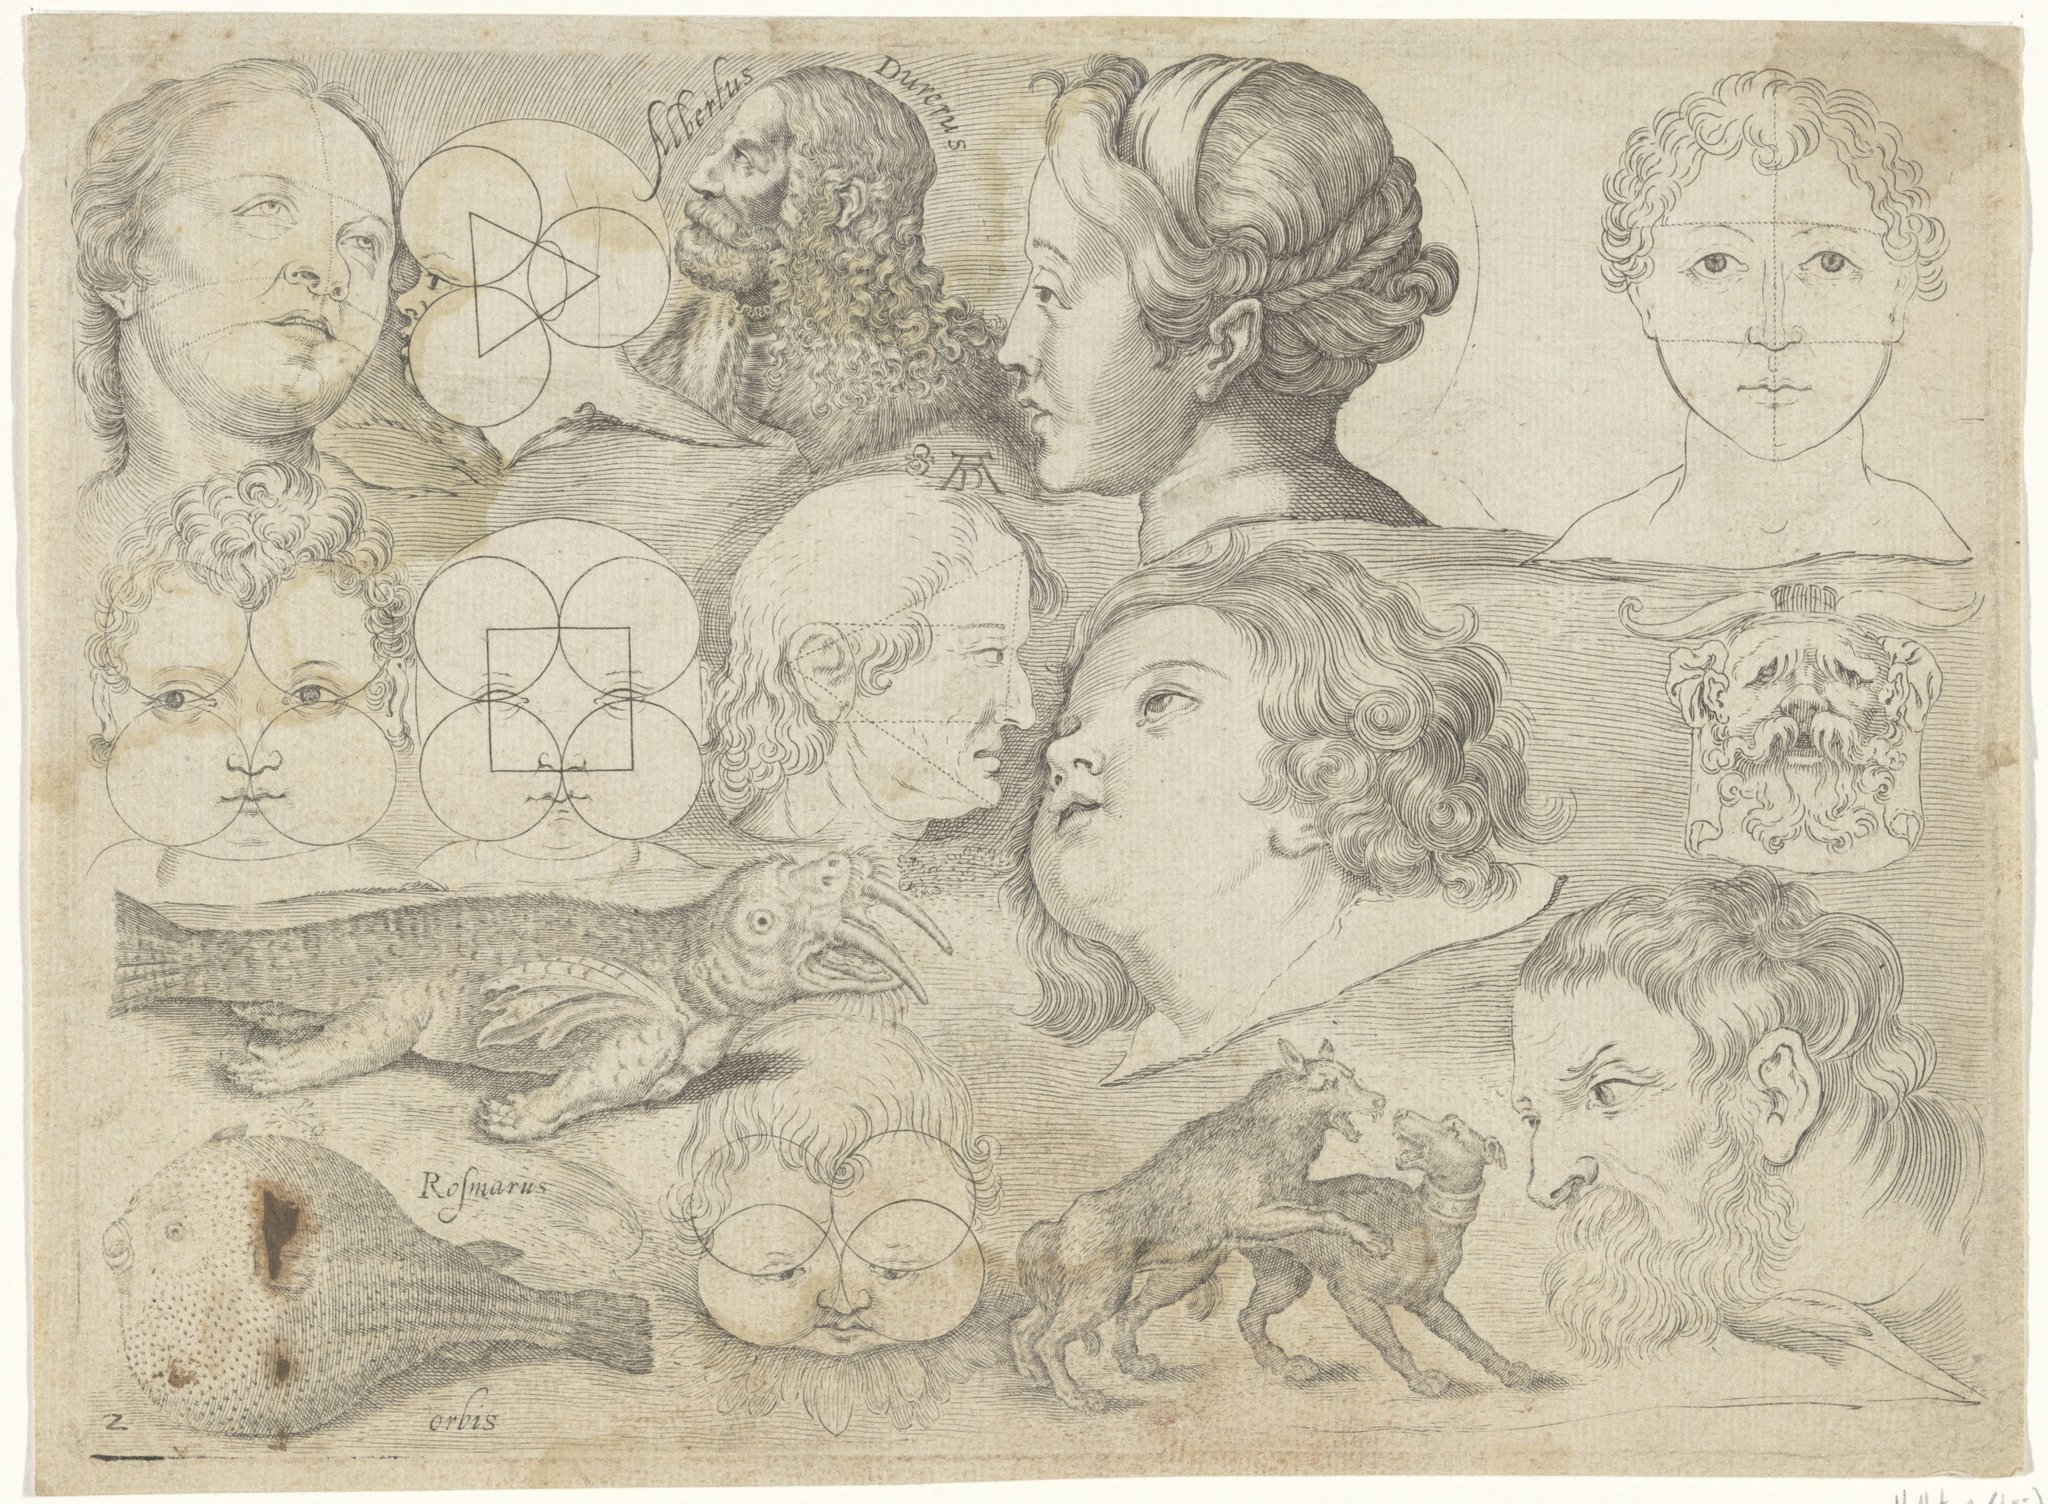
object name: print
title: Tekenvoorbeelden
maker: michael snijders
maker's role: print maker, publisher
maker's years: 1586-1672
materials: paper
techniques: engraving, etching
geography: antwerp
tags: painter, albrecht dürer, bony fishes: pufferfish, swimming mammals: walrus - fabulous animals (sometimes wrongly called 'grotesques'); 'mostri', dog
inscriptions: collector's mark: Lugt 2228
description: Tweede prent uit een serie tekenvoorbeelden van onbekende omvang. Studieblad met vrouwen- en mannenkoppen: middenboven het zelfportret van Dürer. Links een kogelvis en een op een walrus lijkend fantasiedier. Middenonder twee honden.